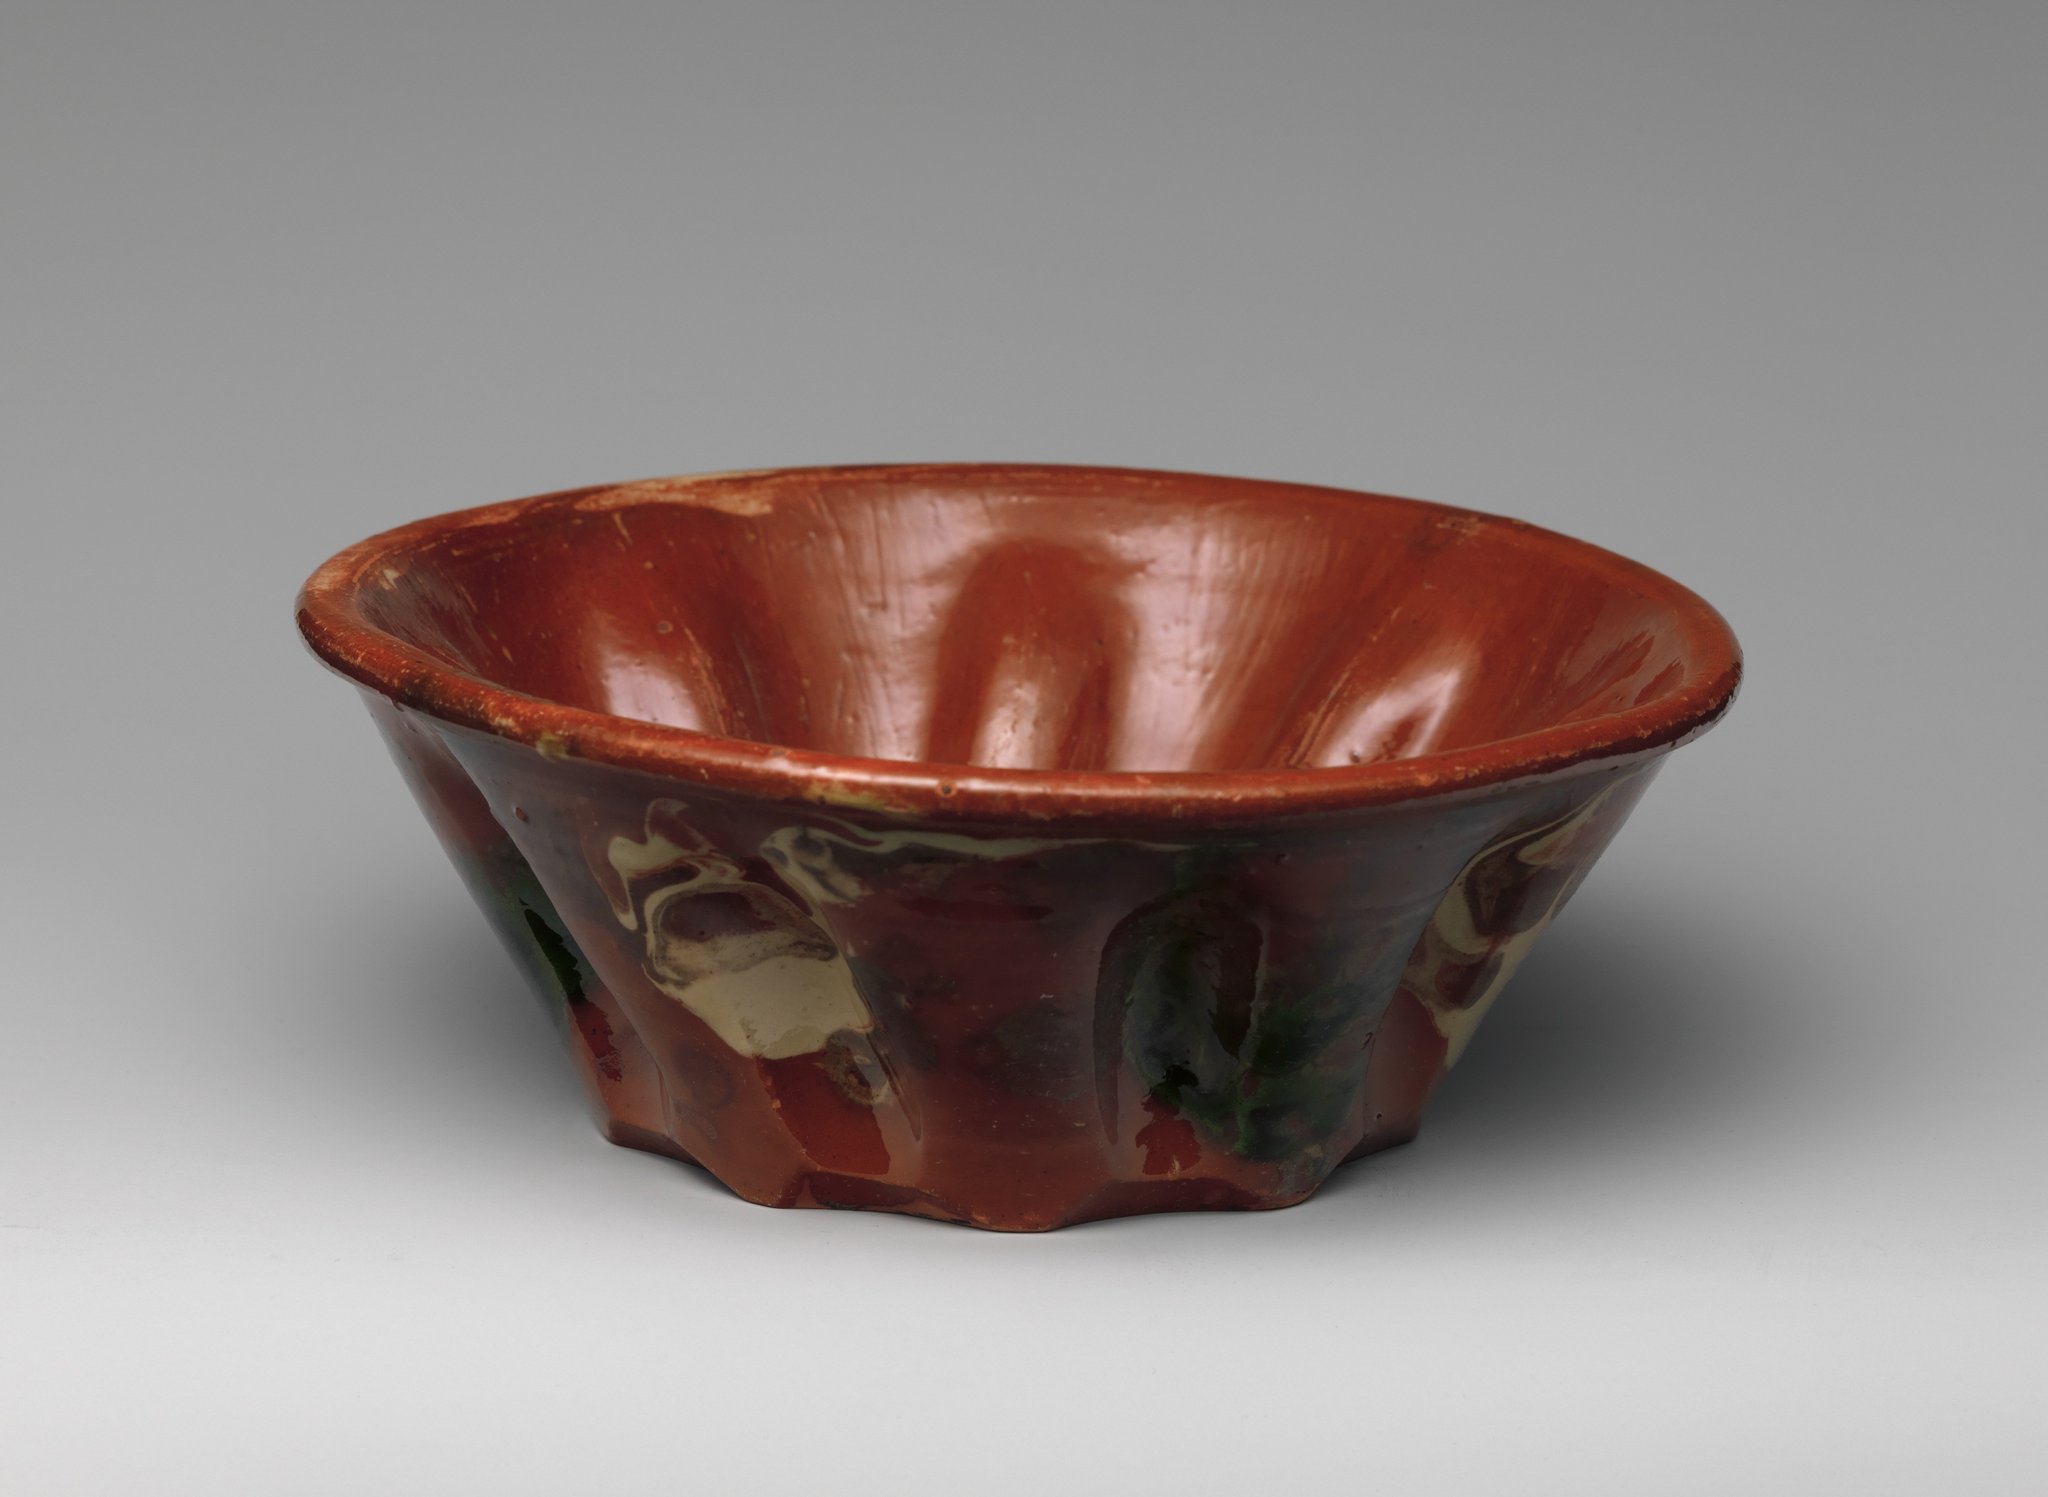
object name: bowl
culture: american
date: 1820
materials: earthenware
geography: united states